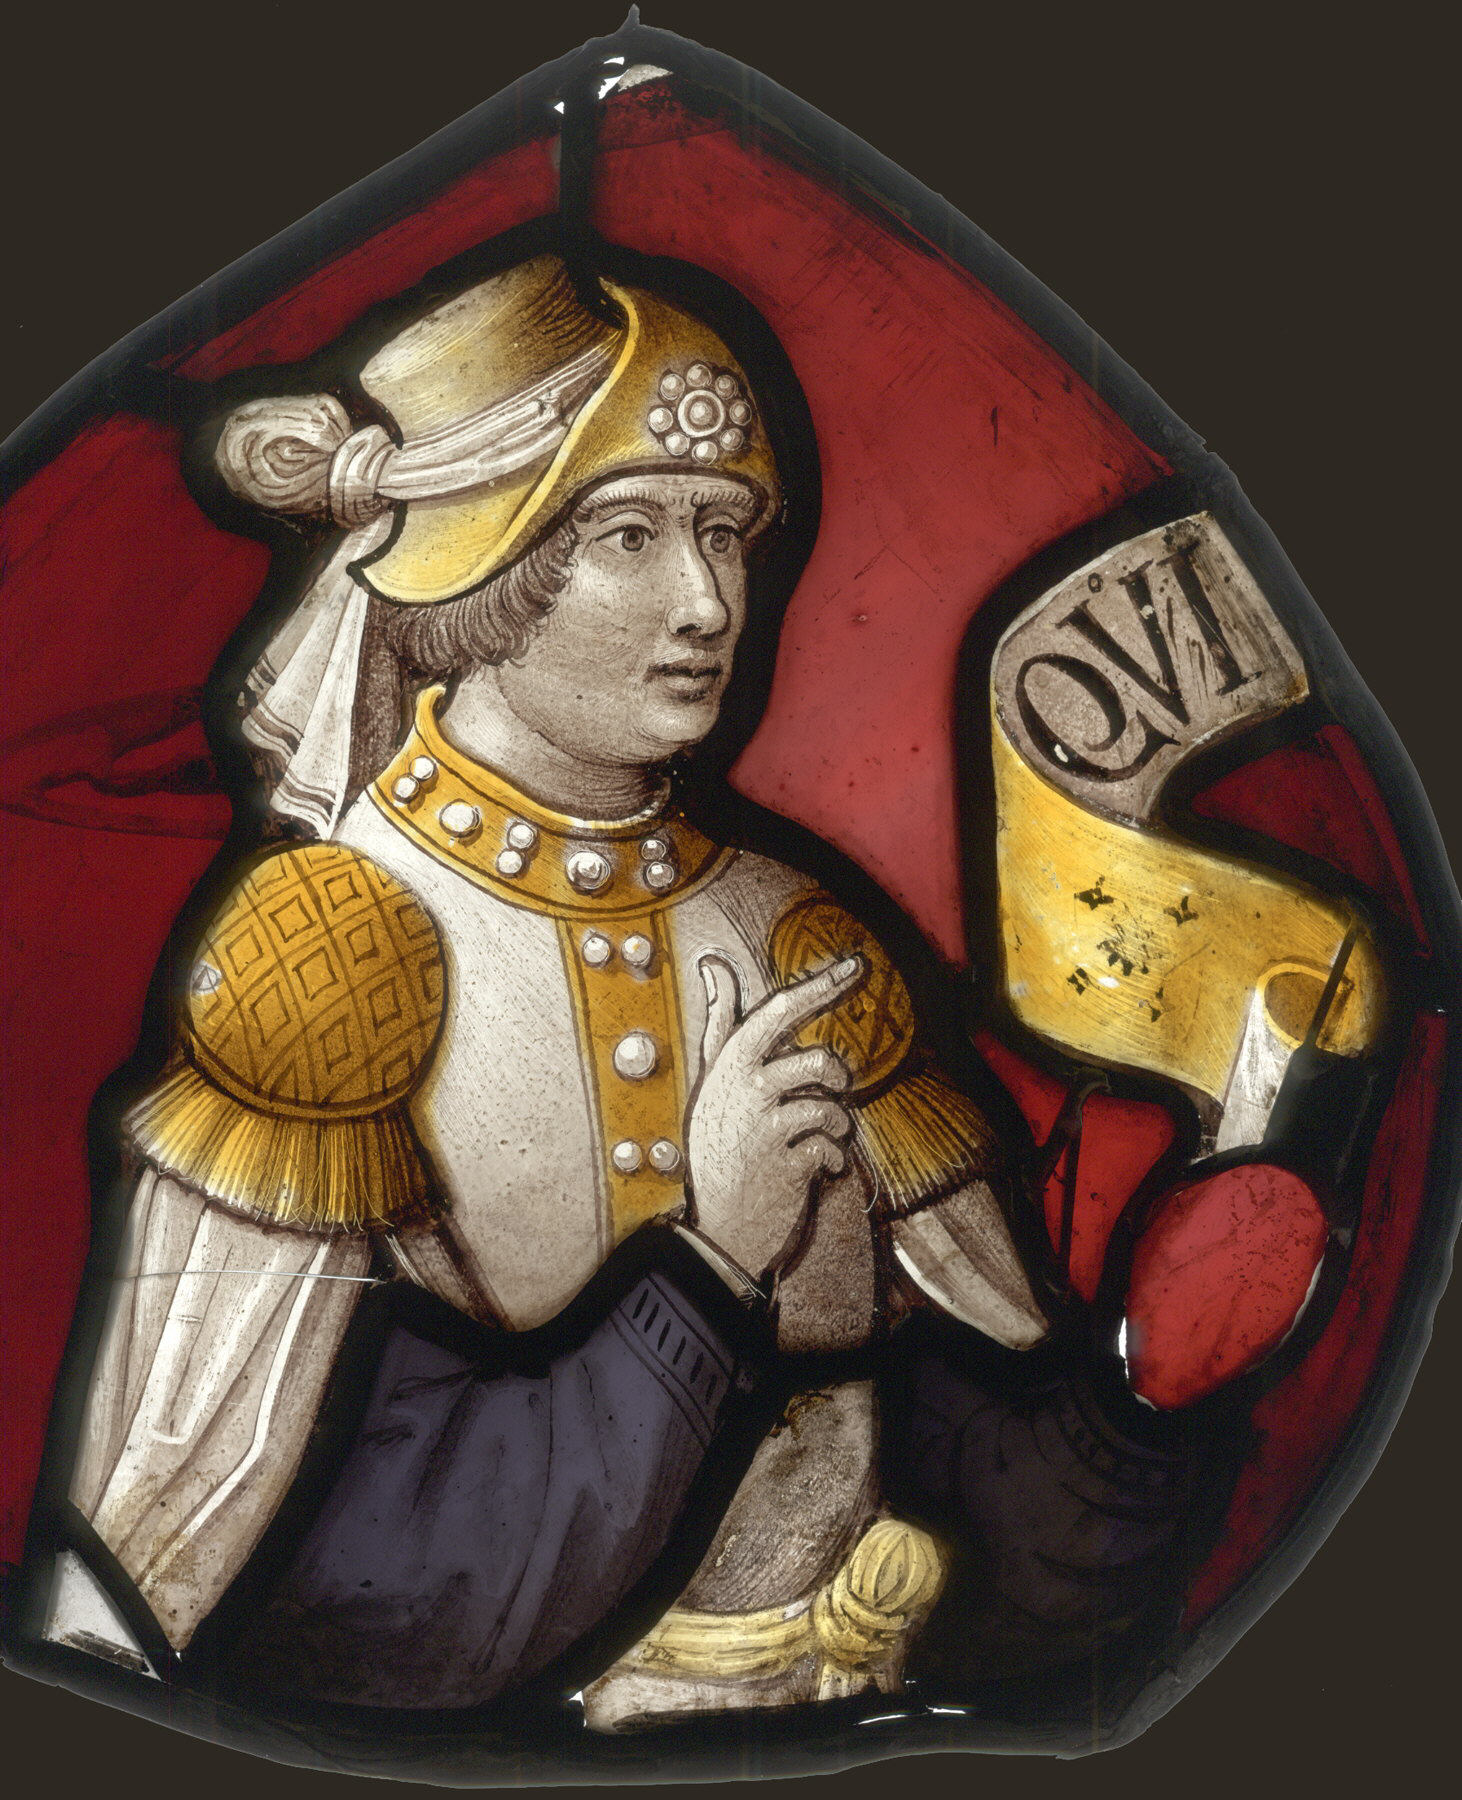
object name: panel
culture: german or south netherlandish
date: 1401-1500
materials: glass, paint, pigment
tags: men